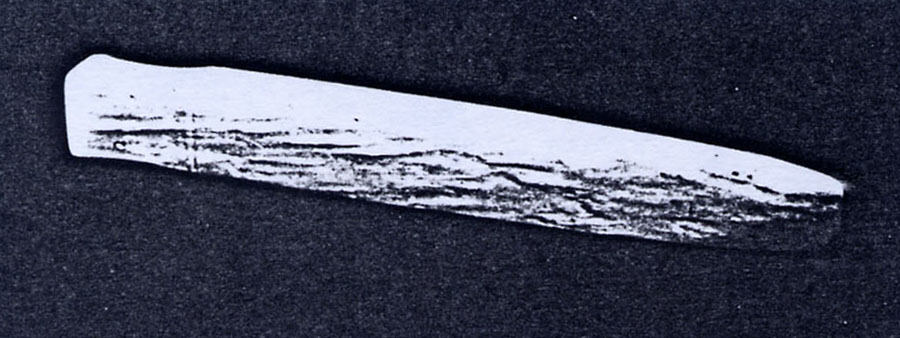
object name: object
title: Handle-shaped object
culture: chinese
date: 1600-1046 BCE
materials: jade